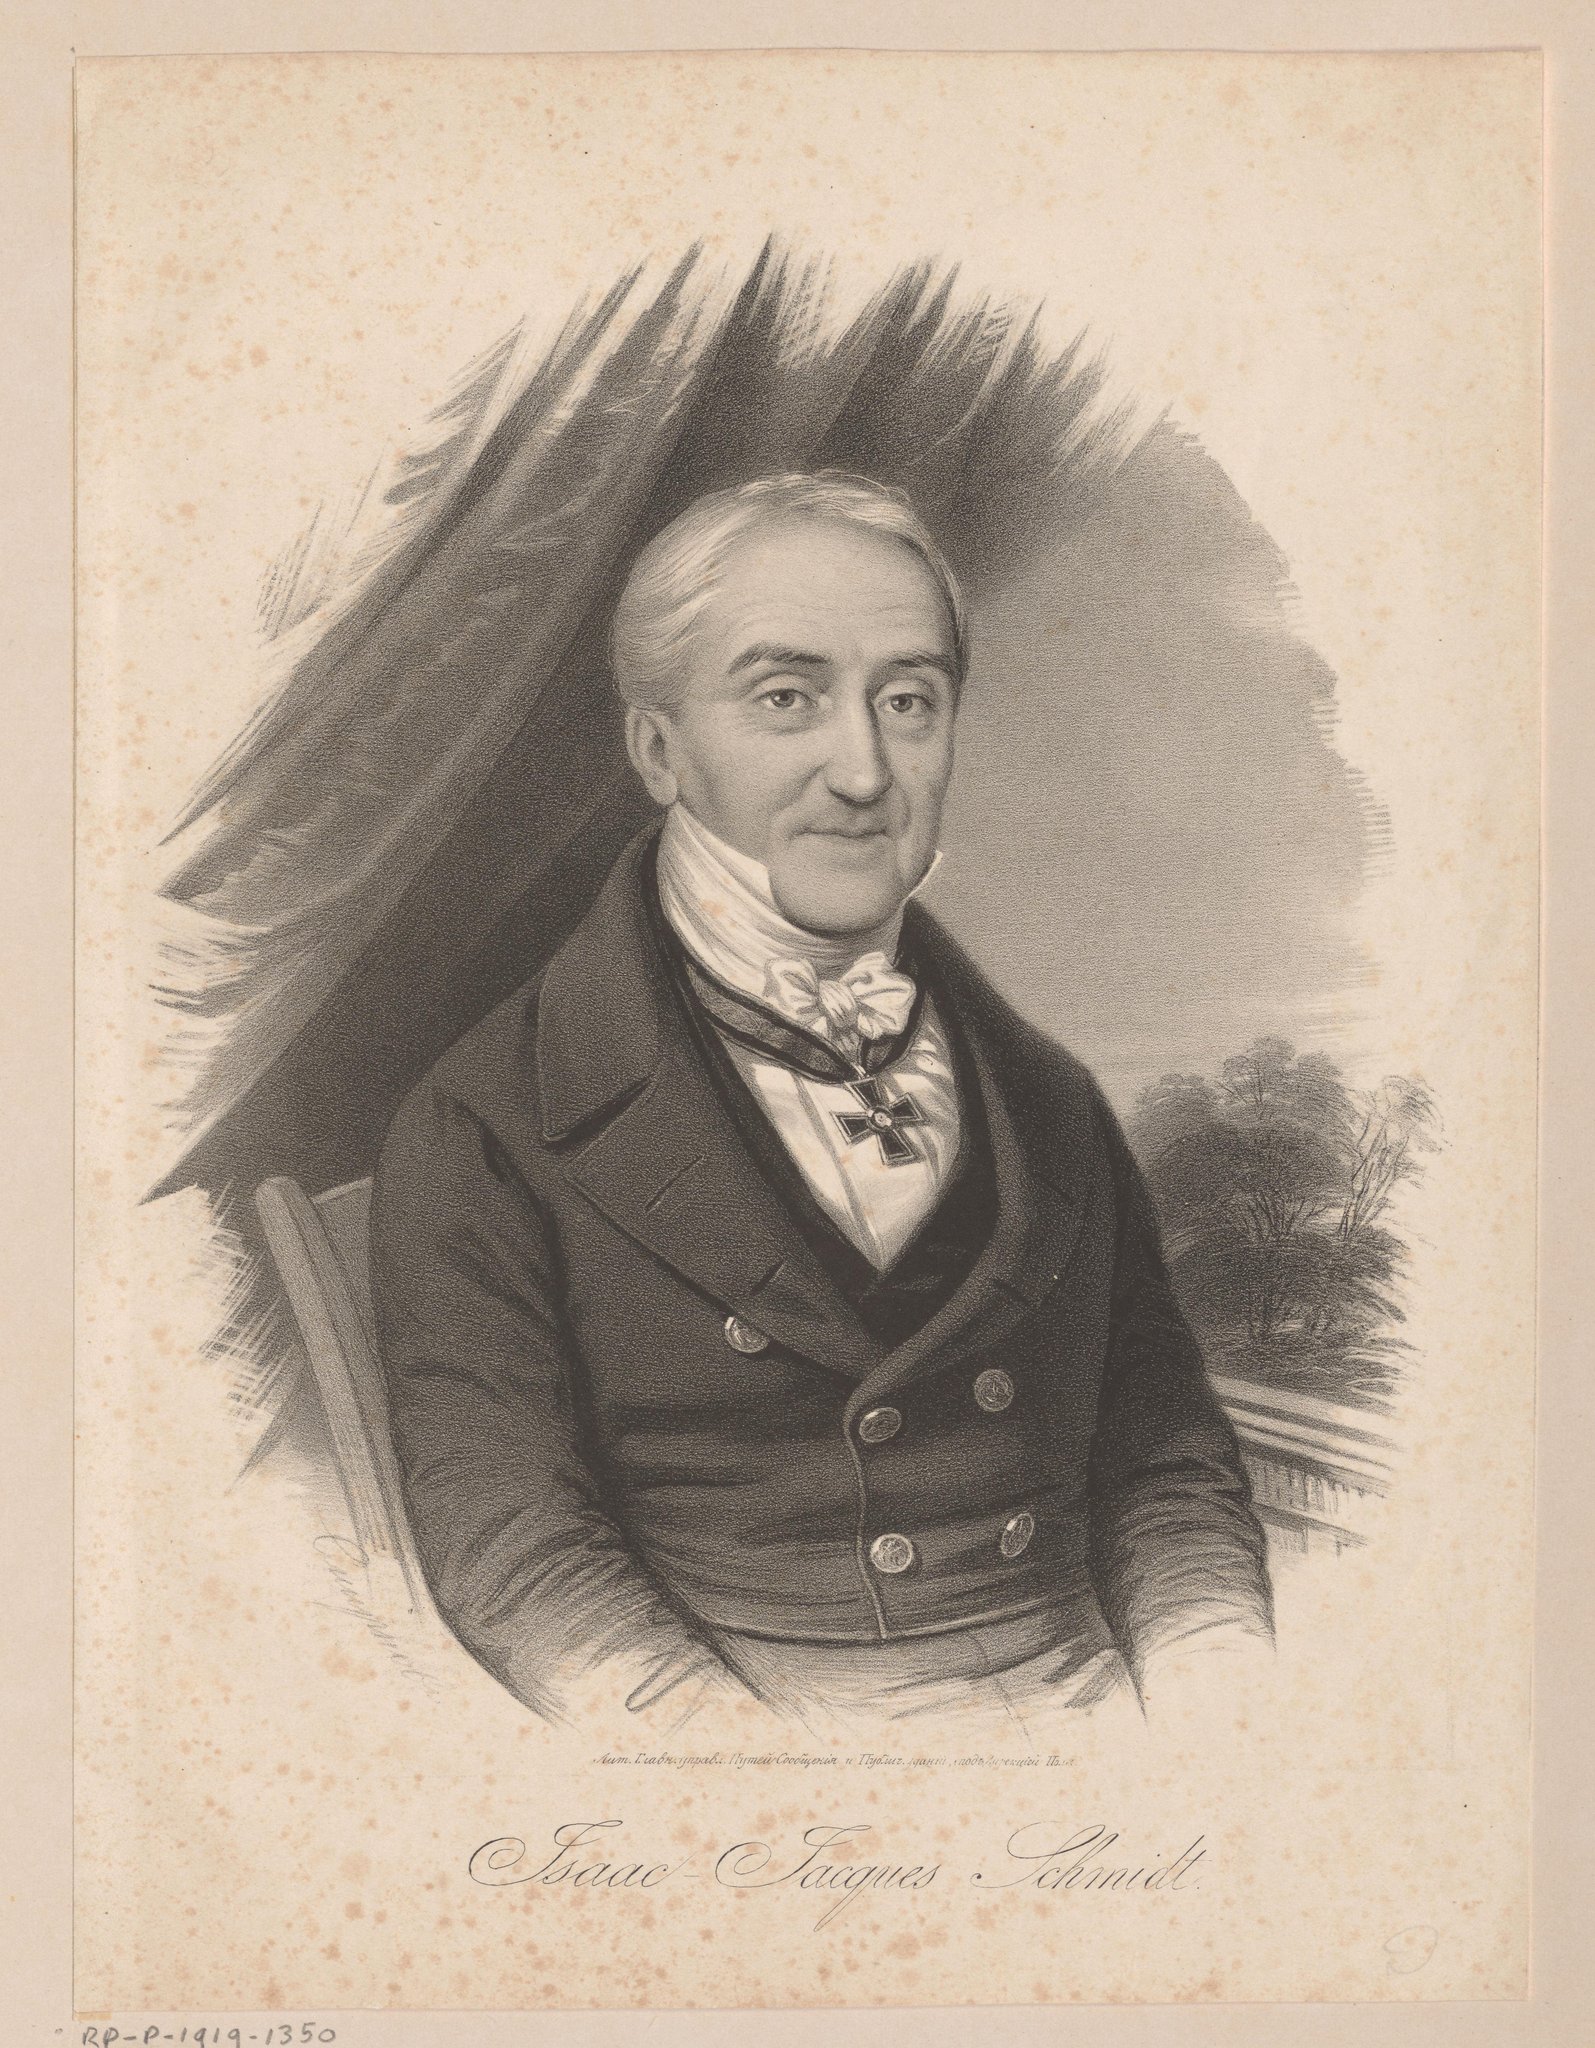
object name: print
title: Portret van Isaac Jacob Schmidt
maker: Anonymous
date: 1820-1860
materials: paper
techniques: lithograph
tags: adult man, historical persons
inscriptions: collector's mark: Lugt 2228